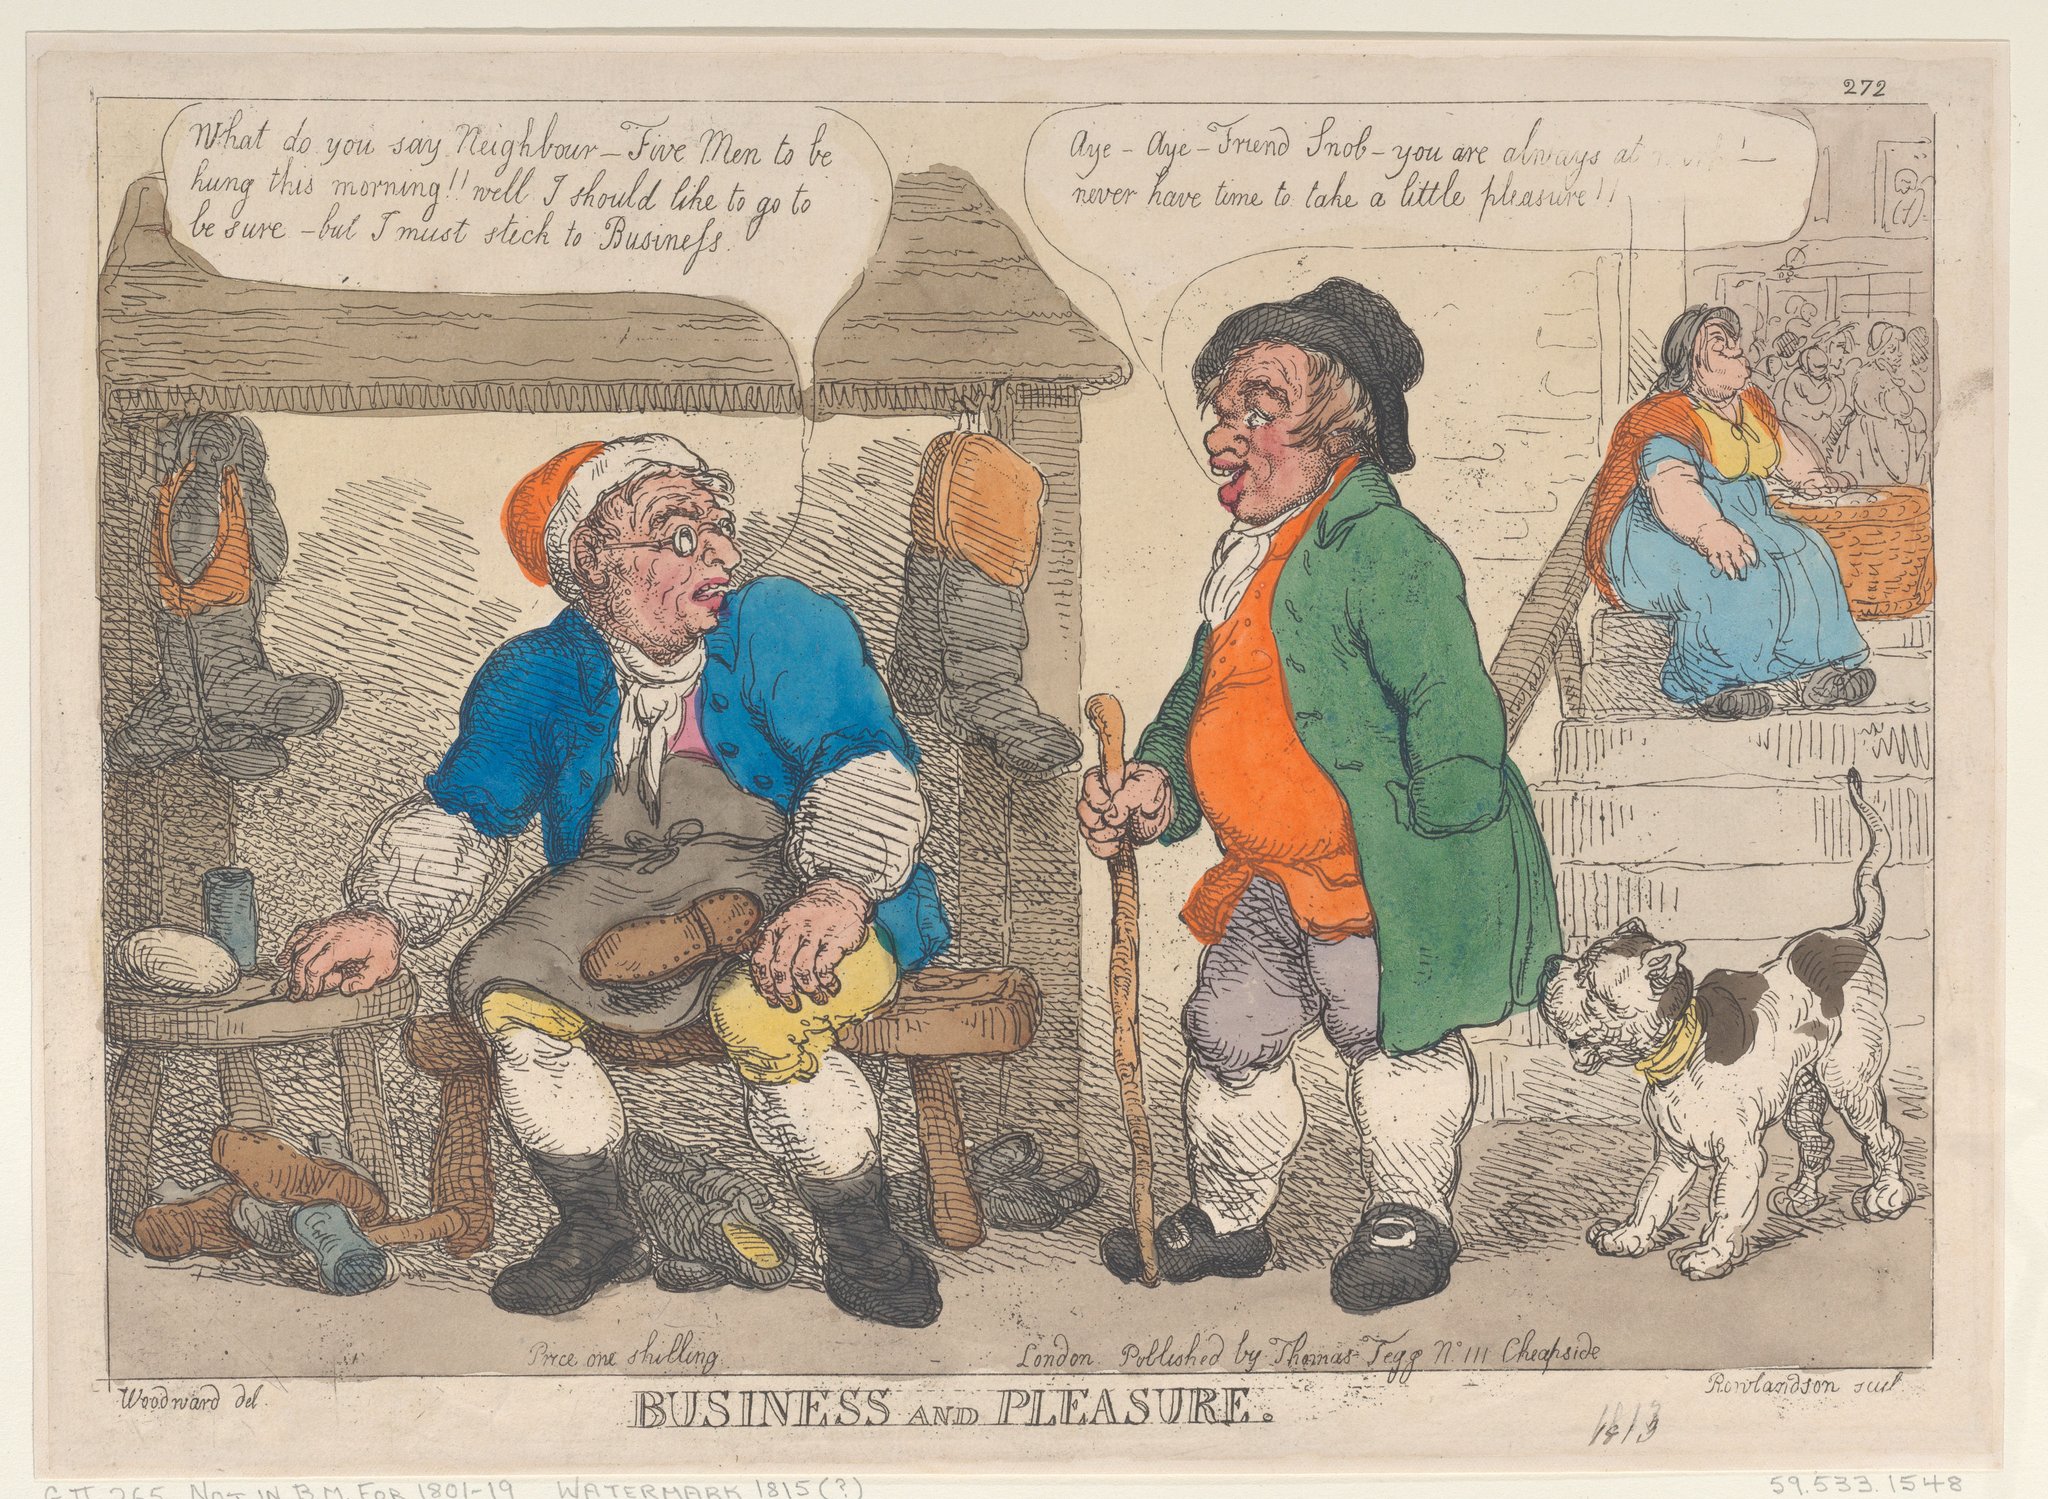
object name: print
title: Business and Pleasure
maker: thomas rowlandson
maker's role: artist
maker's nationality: british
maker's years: 1757-1827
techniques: etching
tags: satire,shoes,men,dogs